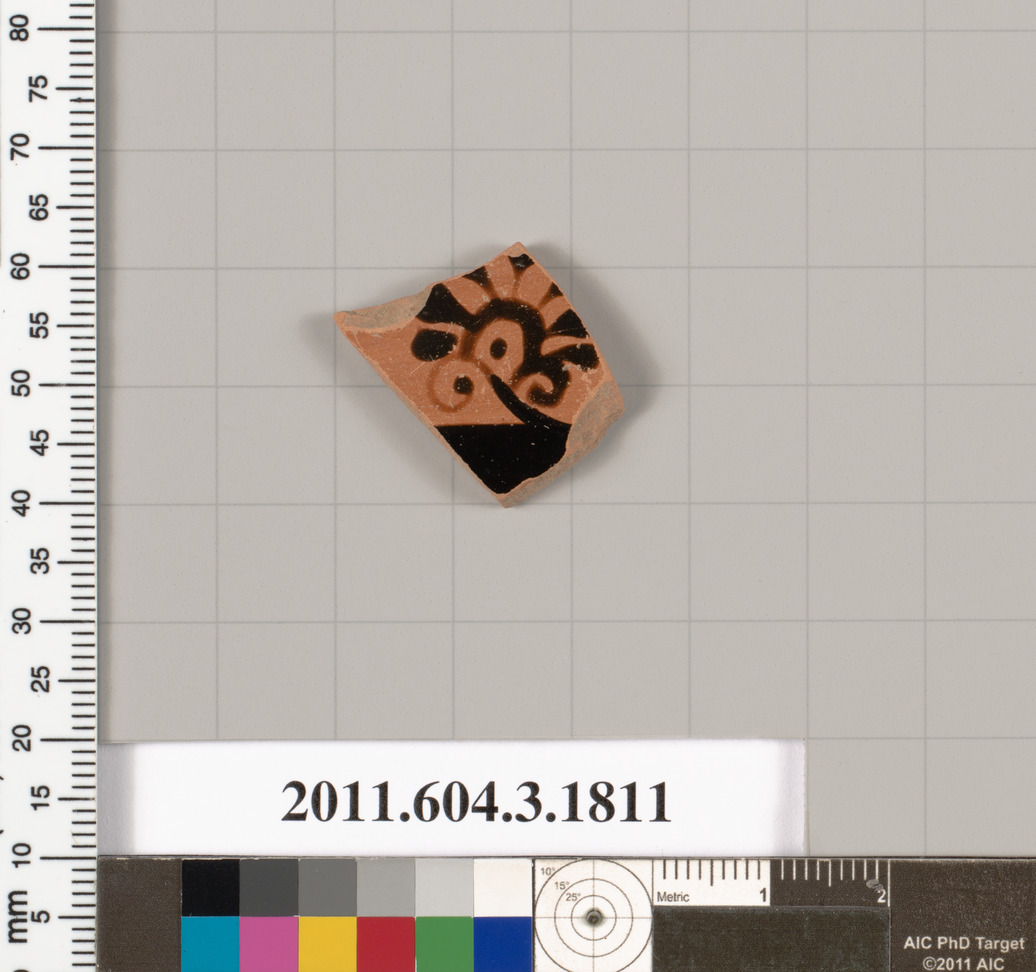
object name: kylix fragment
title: Terracotta fragment of a kylix: Lip cup (drinking cup)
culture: greek, attic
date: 550-526 BCE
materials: terracotta